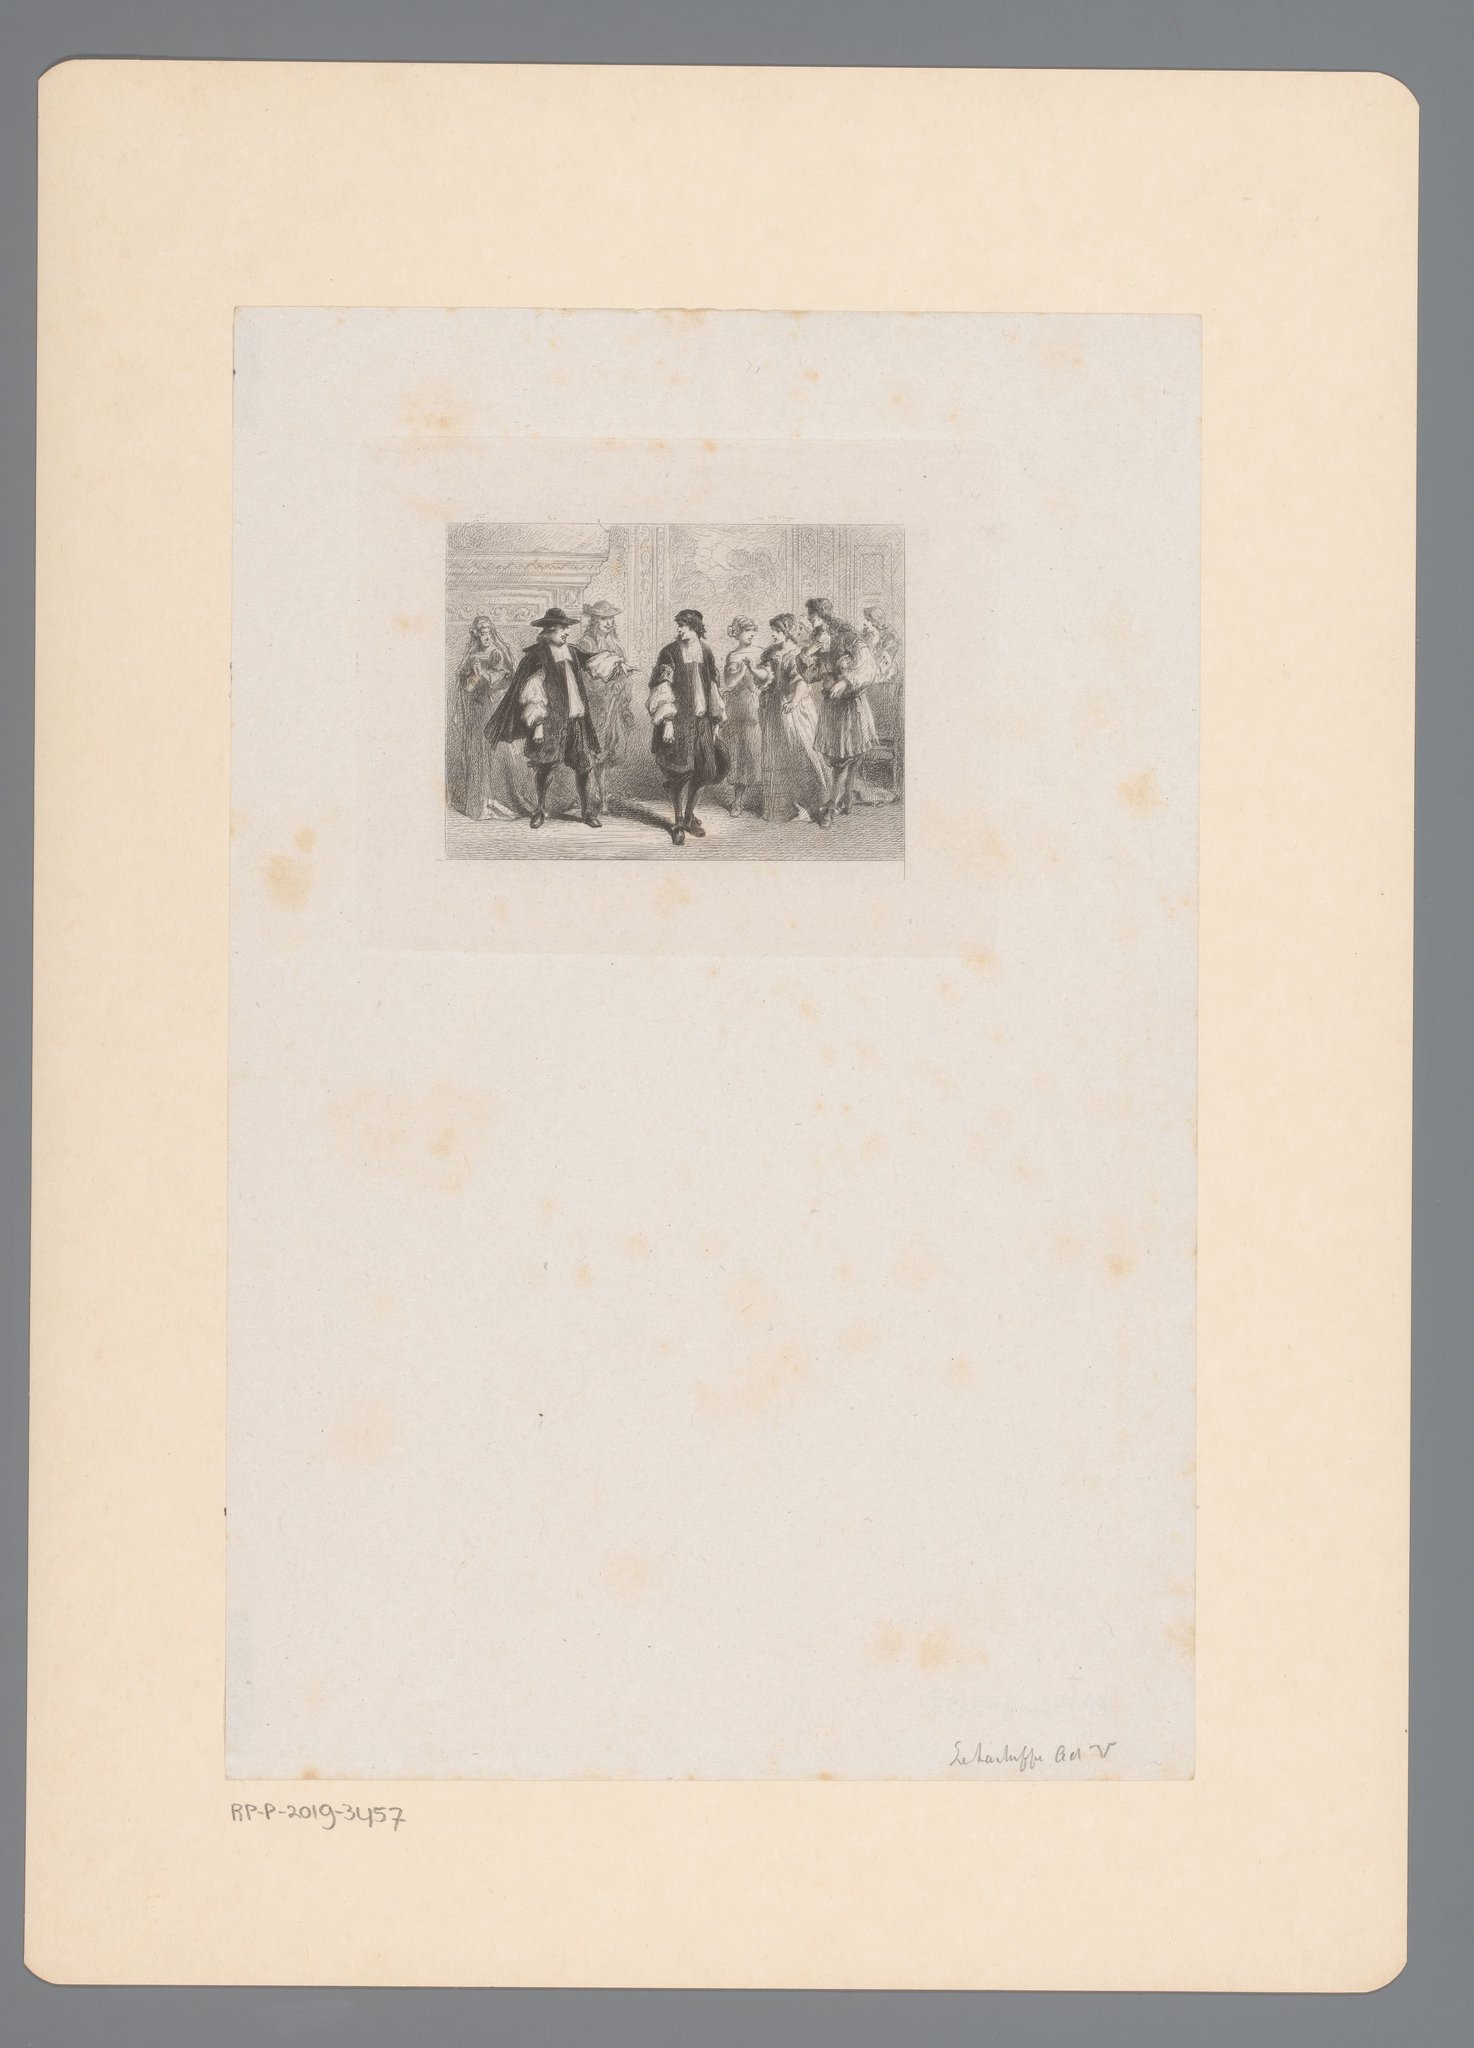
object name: print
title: Monsieur Loyal gebiedt Orgon het huis te verlaten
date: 1878-1879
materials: paper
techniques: drypoint, etching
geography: tours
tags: theatre, theatrical performance, visiting; receiving guests; elegant company, housing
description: Akte V, scène IV uit "Le Tartuffe" van Molière. Omdat het huis volgens de papieren nu aan Tartuffe behoort, wordt Orgon eruit gezet.